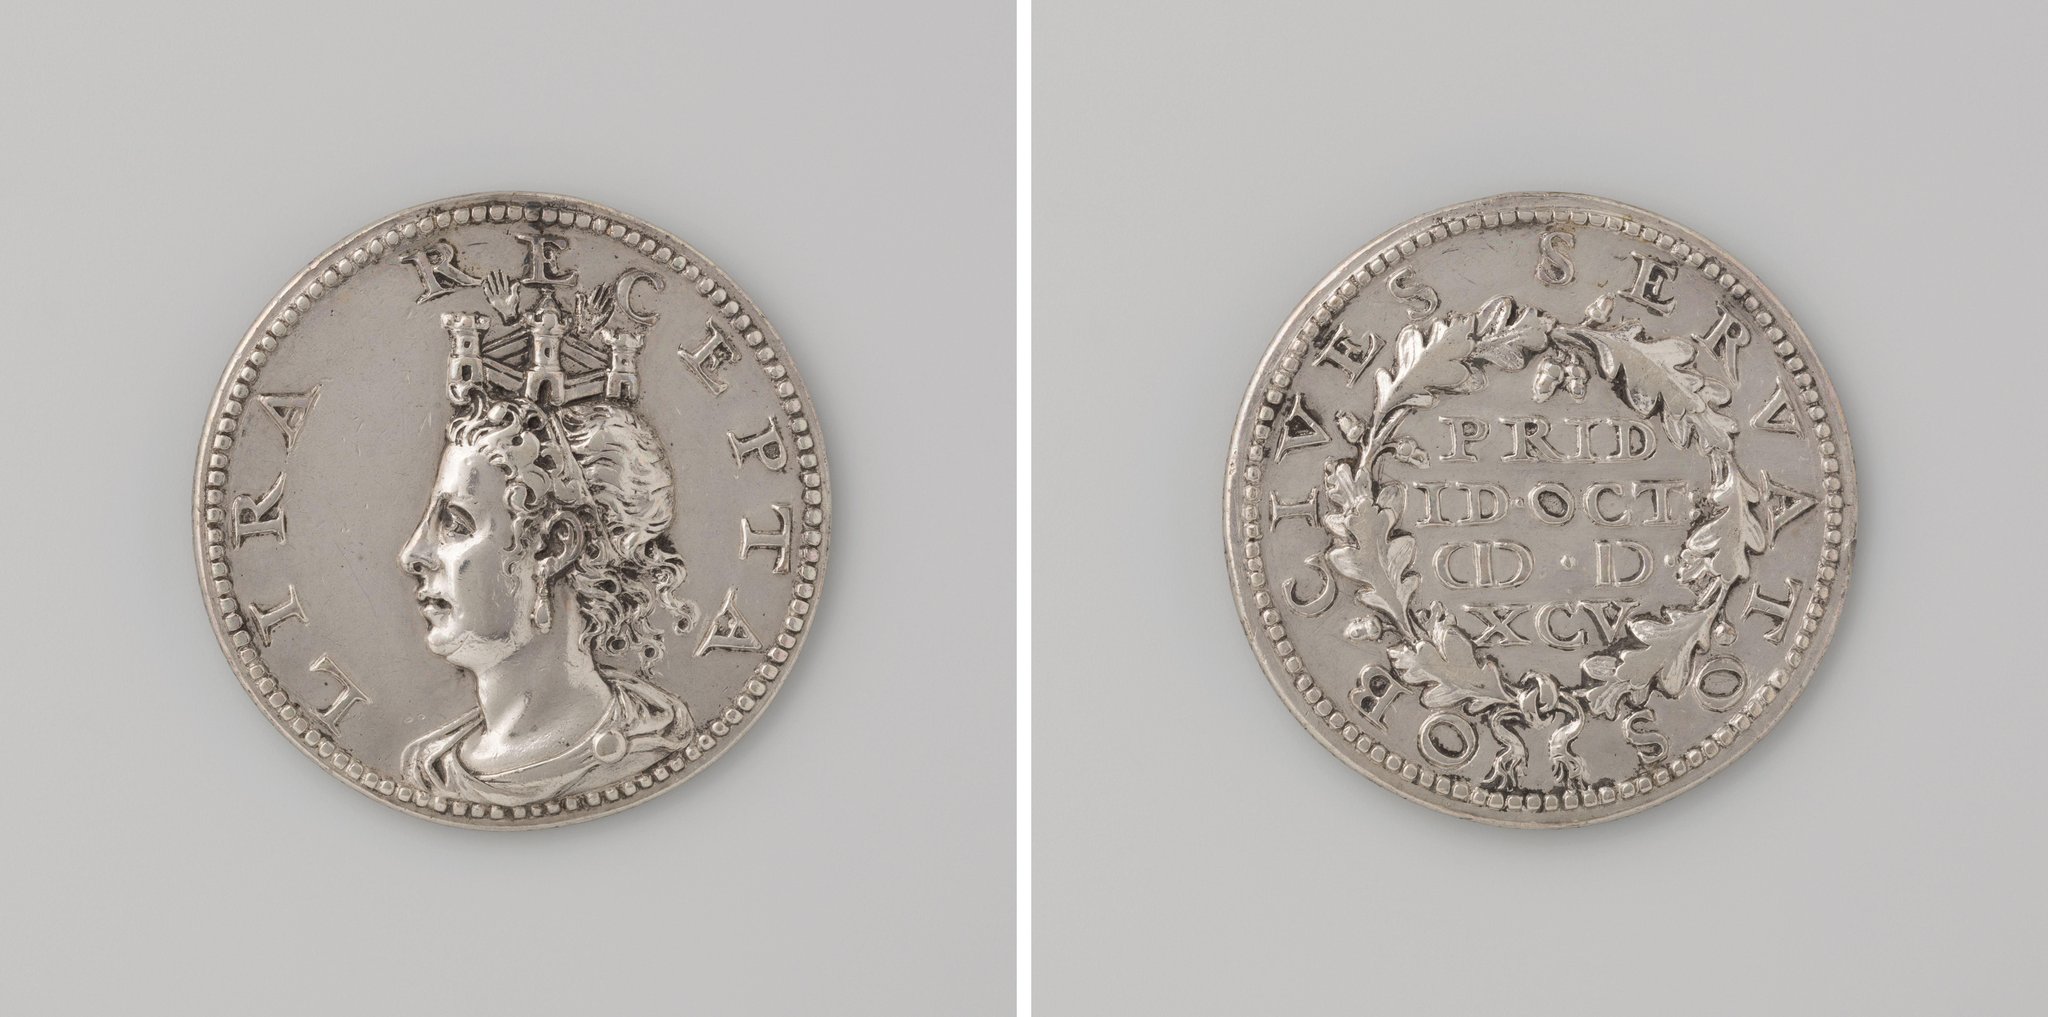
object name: copy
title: Inname van Lier, penning geschonken aan de burgers van Antwerpen die de stad verdedigden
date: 1595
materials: silver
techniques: casting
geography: antwerp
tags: lierre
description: Zilveren penning. Voorzijde: vrouw met stedekroon binnen omschrift. Keerzijde: opschrift binnen eikenkrans en omschrift